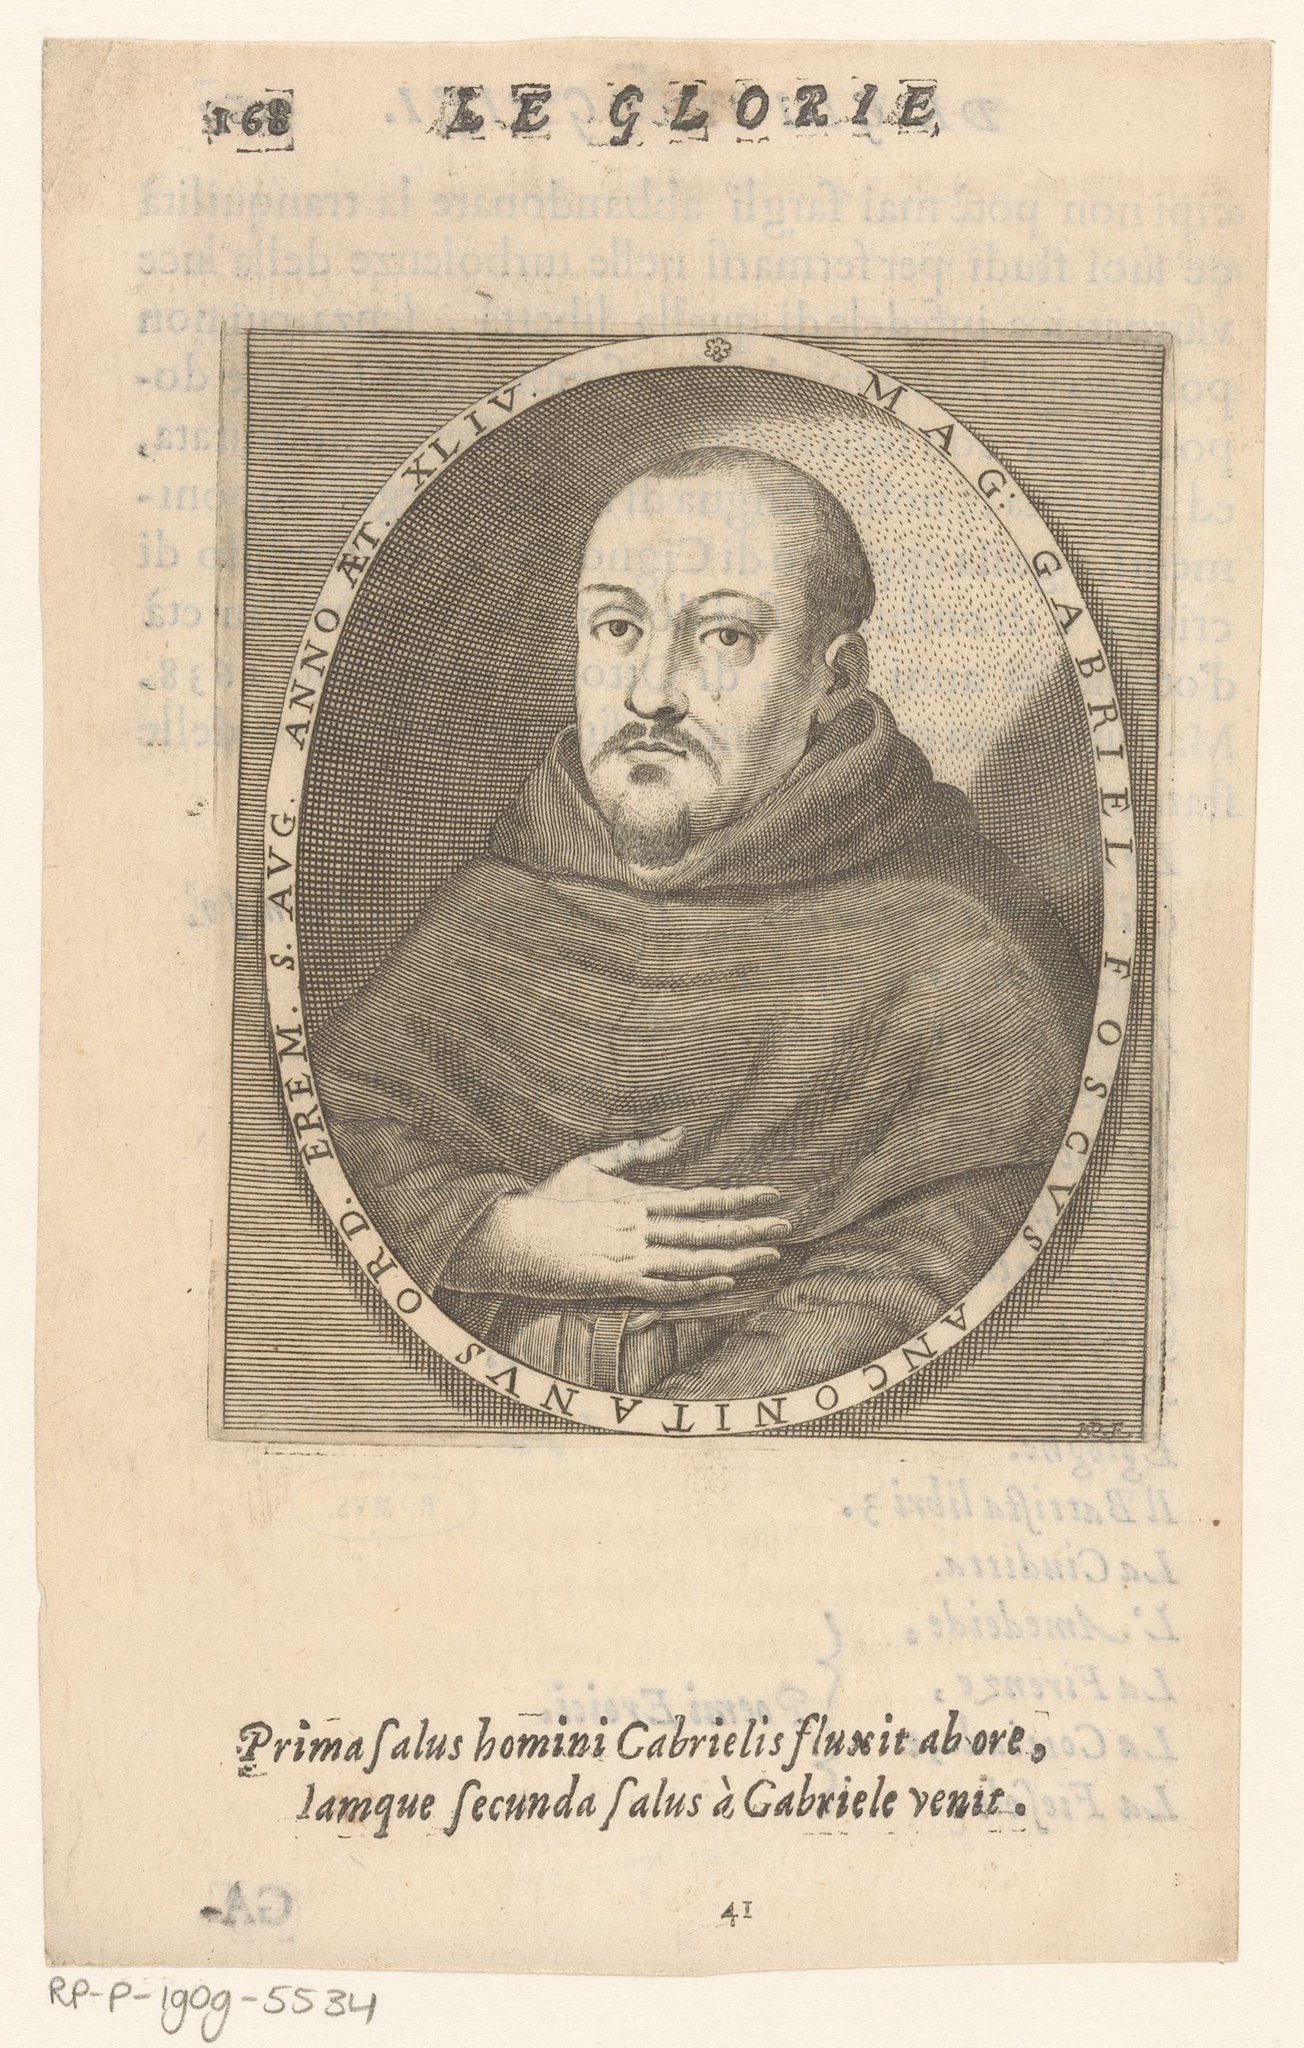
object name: print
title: Portret van geestelijke Gabriel Foschi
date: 1647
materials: paper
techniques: engraving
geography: venice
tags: historical persons, regular clerics, e.g. jesuits, redemptorists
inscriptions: collector's mark: Lugt 2228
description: Prent gebruikt voor: Loredano, Giovanni Francesco of Brusoni, Girolamo. Le glorie de gli incogniti: O vero gli huomini illustri dell'accademia de'signori incogniti di Venetia. Venetië: Appresso Francesco Valuasense, 1647, p. 168.